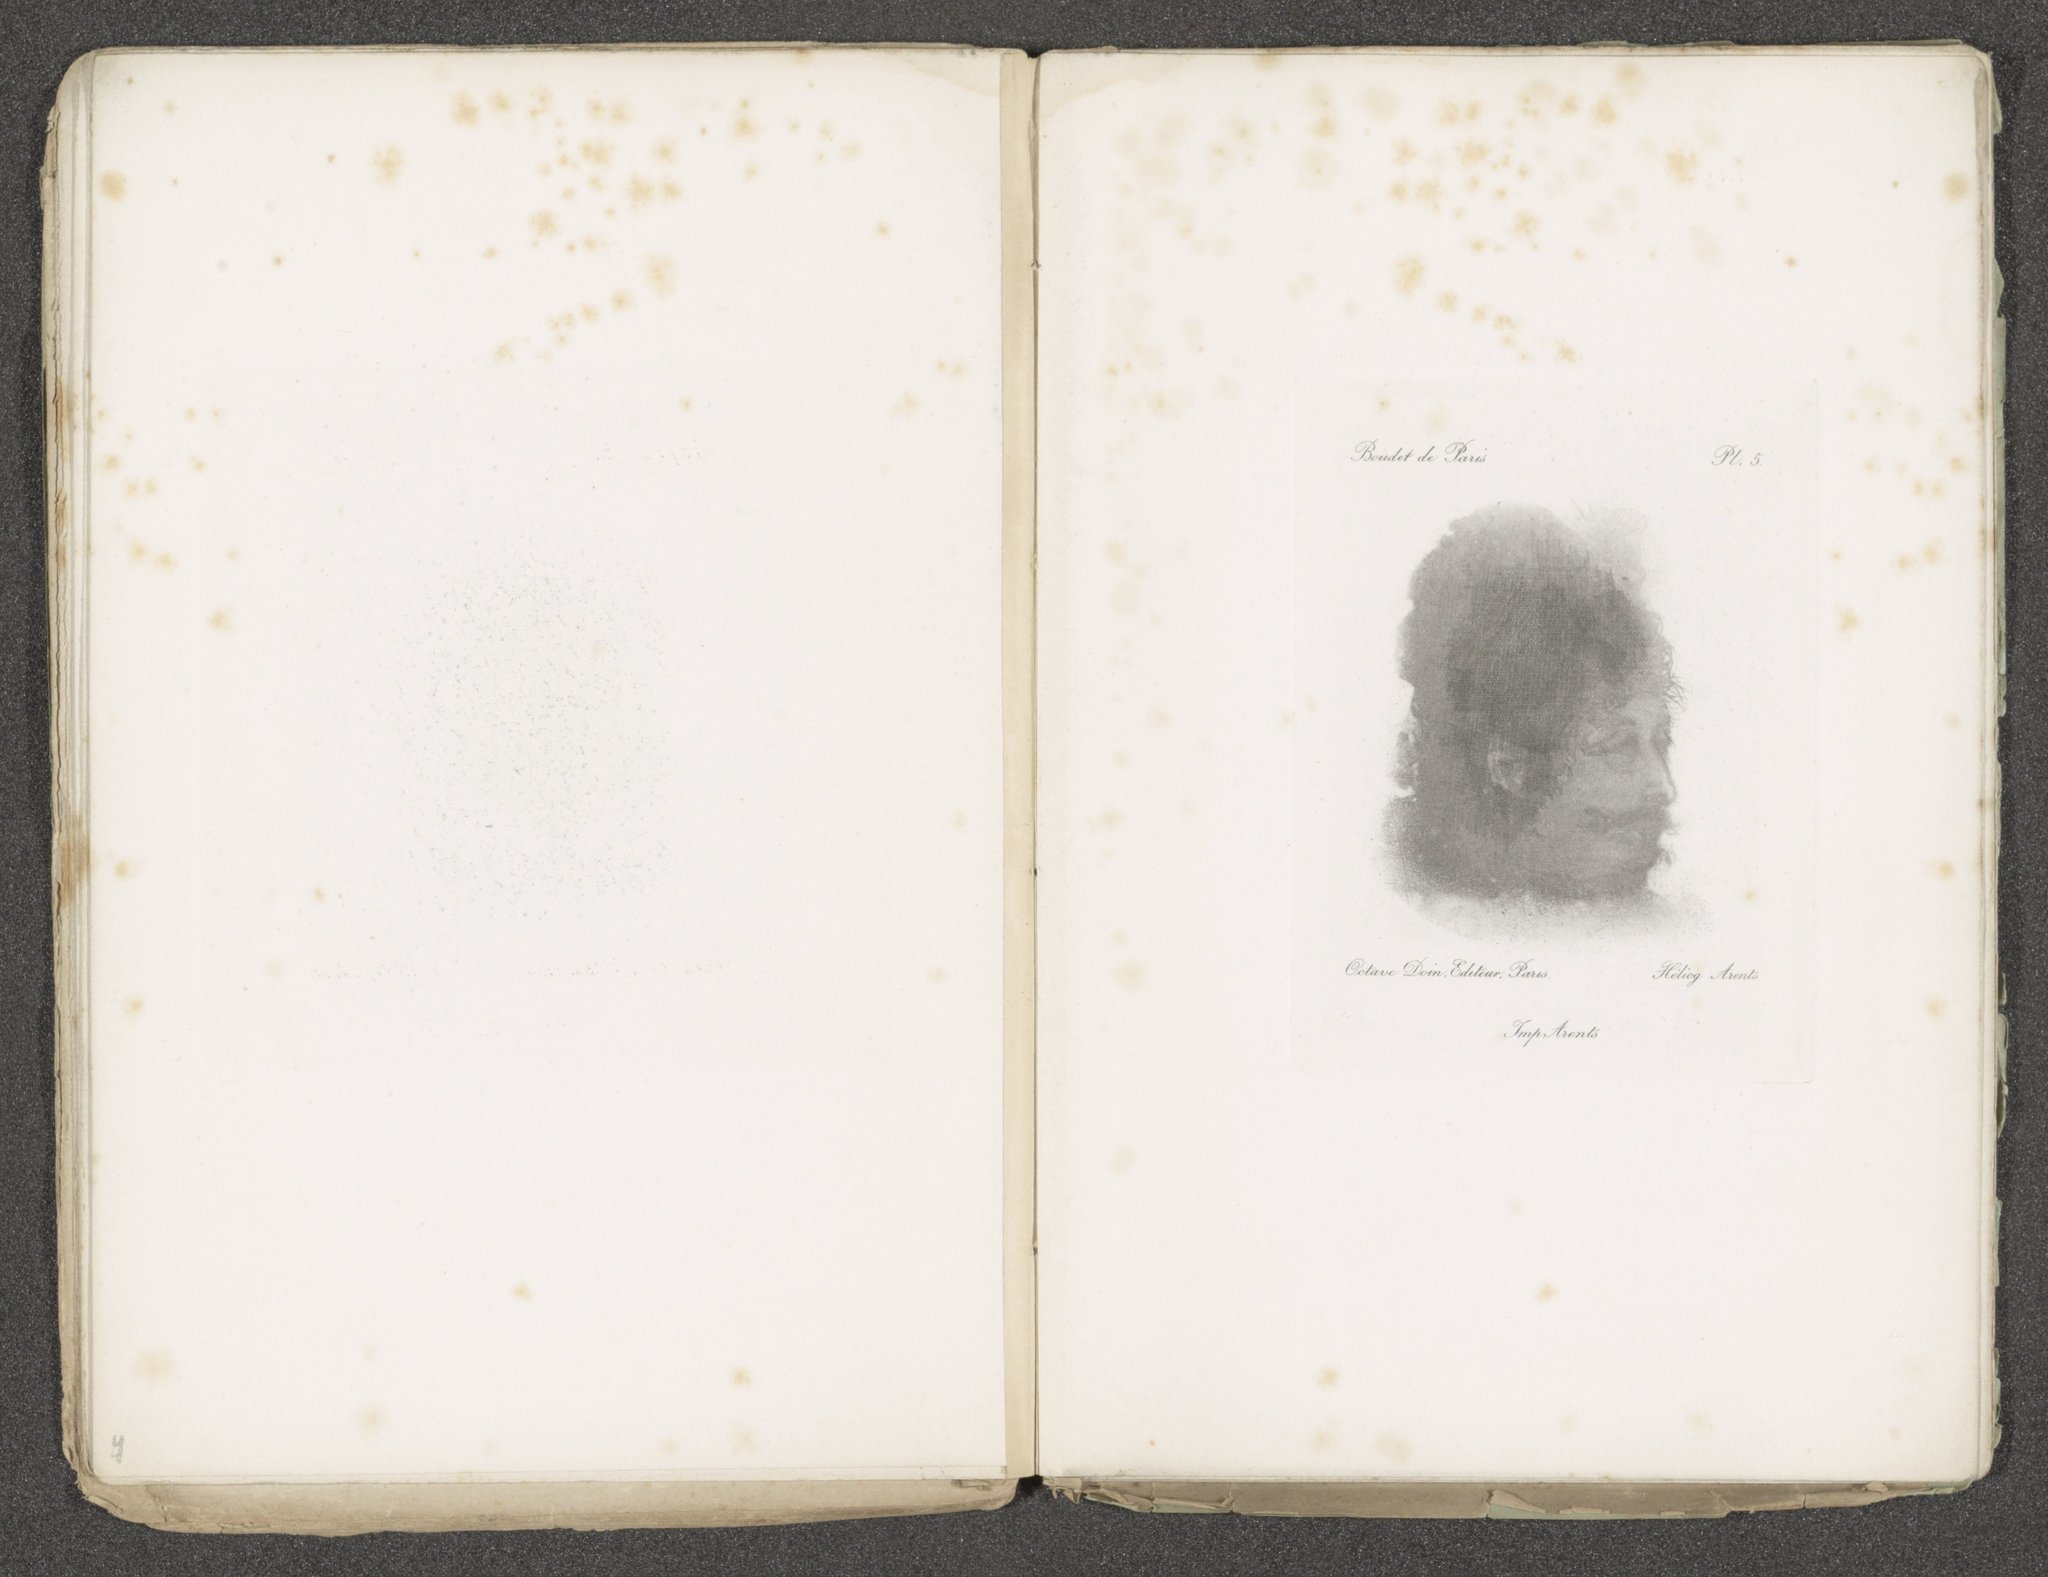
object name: photomechanical print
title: Fotoreproductie van een tekening, voorstellende een portret van een onbekende man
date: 1876-1886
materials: paper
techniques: photoaquatint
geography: paris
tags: anonymous historical person portrayed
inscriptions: number: ‘Pl. 5.’